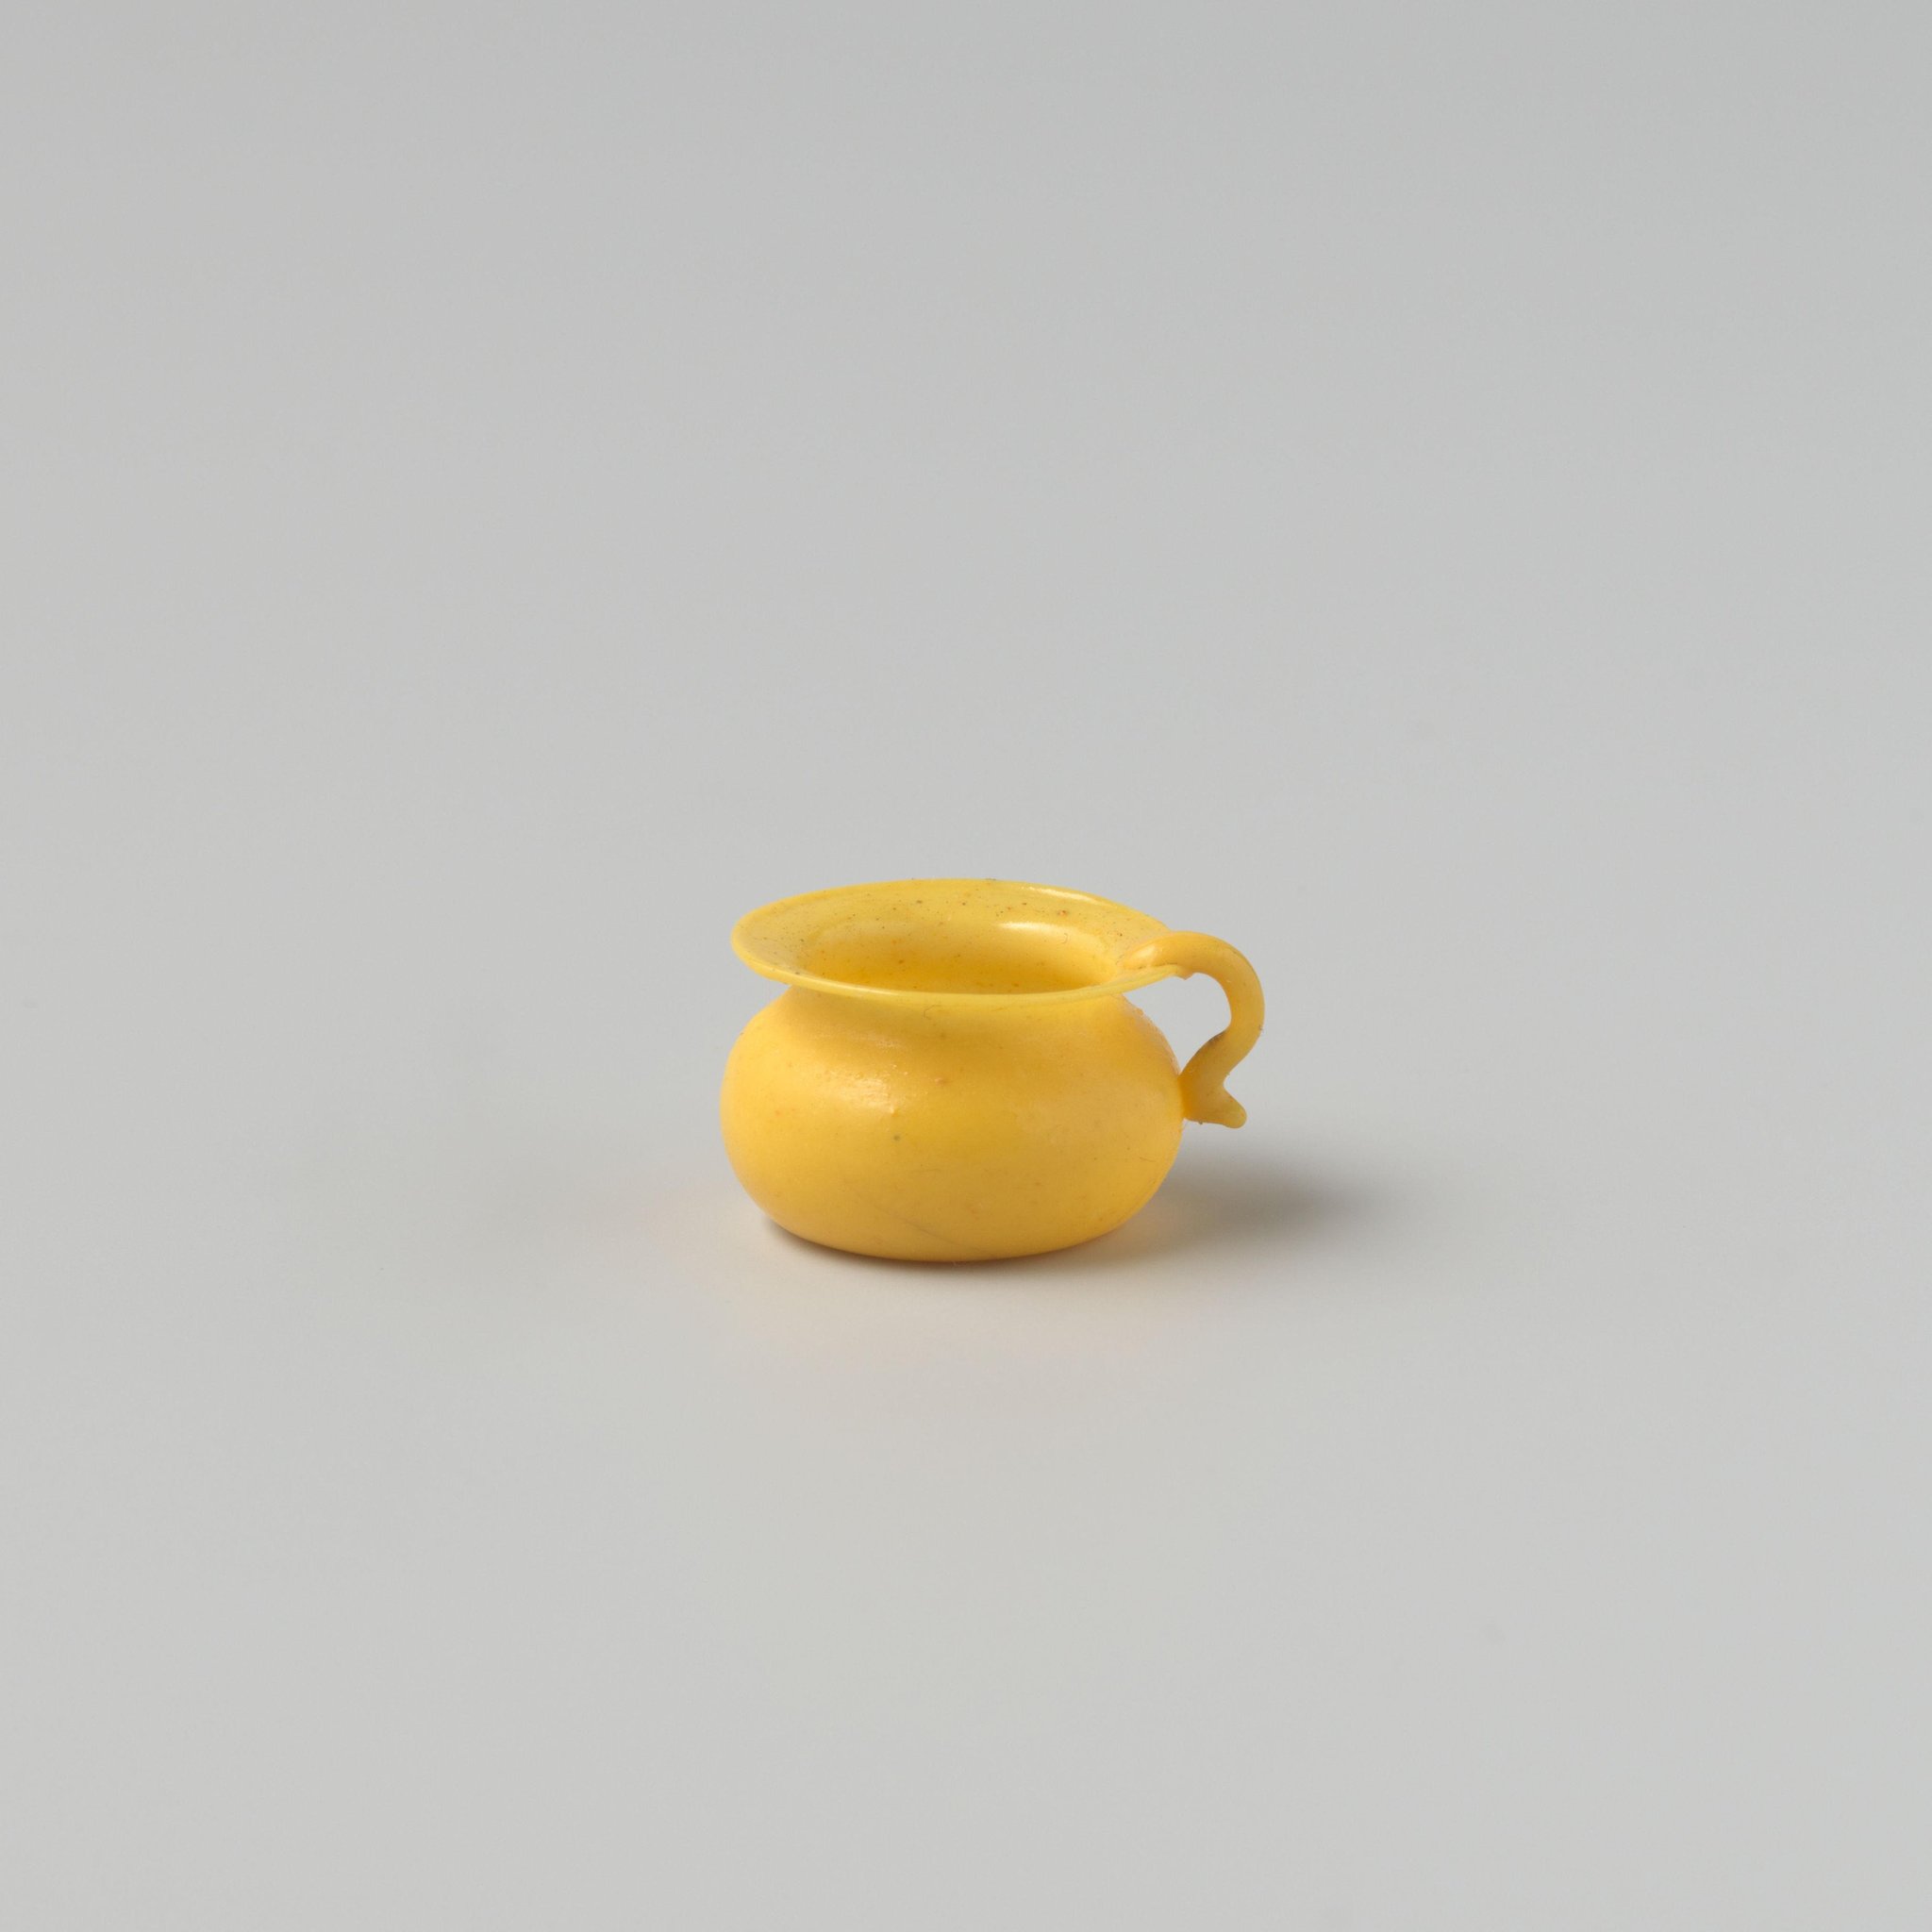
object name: miniature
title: Kamerpot van opaak geel glas (waarschijnlijk imitatie geel aardewerk), laag model met naar binnen gestoken bodem, vlakke halsrand en een aangezet oor.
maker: Anonymous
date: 1675-1710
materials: glass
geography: amsterdam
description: Kamerpot van opaak geel glas, waarschijnlijk imitatie geel aardewerk; laag model met naar binnen gestoken bodem, vlakke halsrand en een aangezet oor.